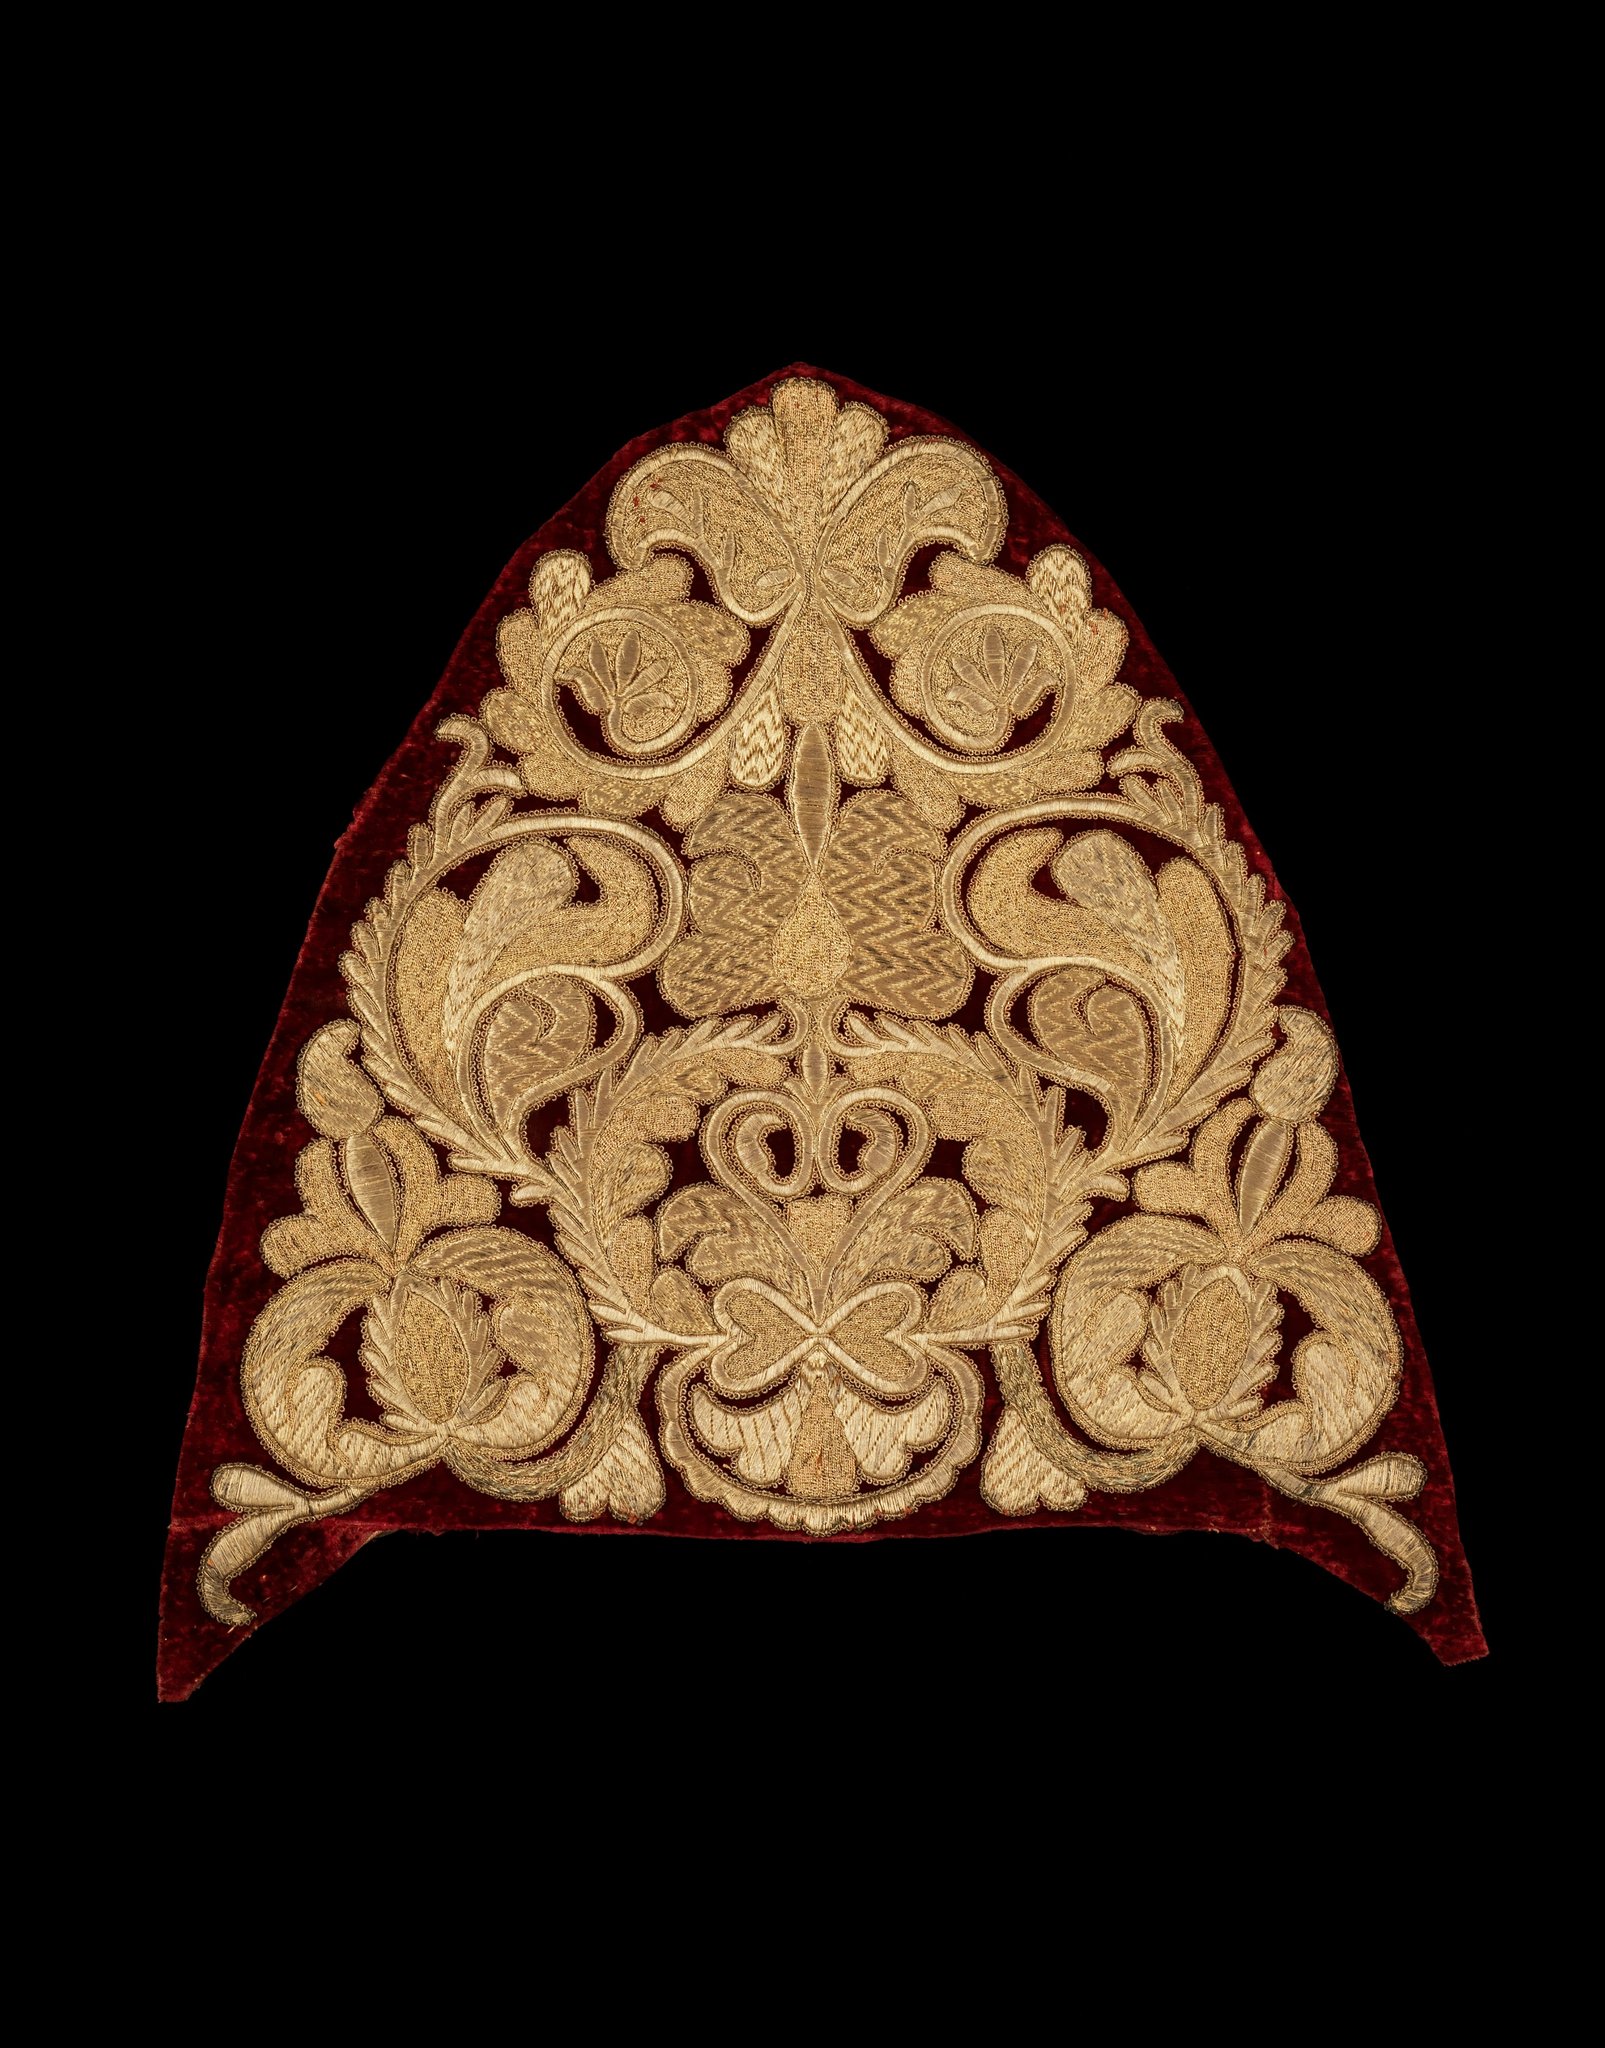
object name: headdress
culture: russian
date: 1830-1880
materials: linen, metal, silk